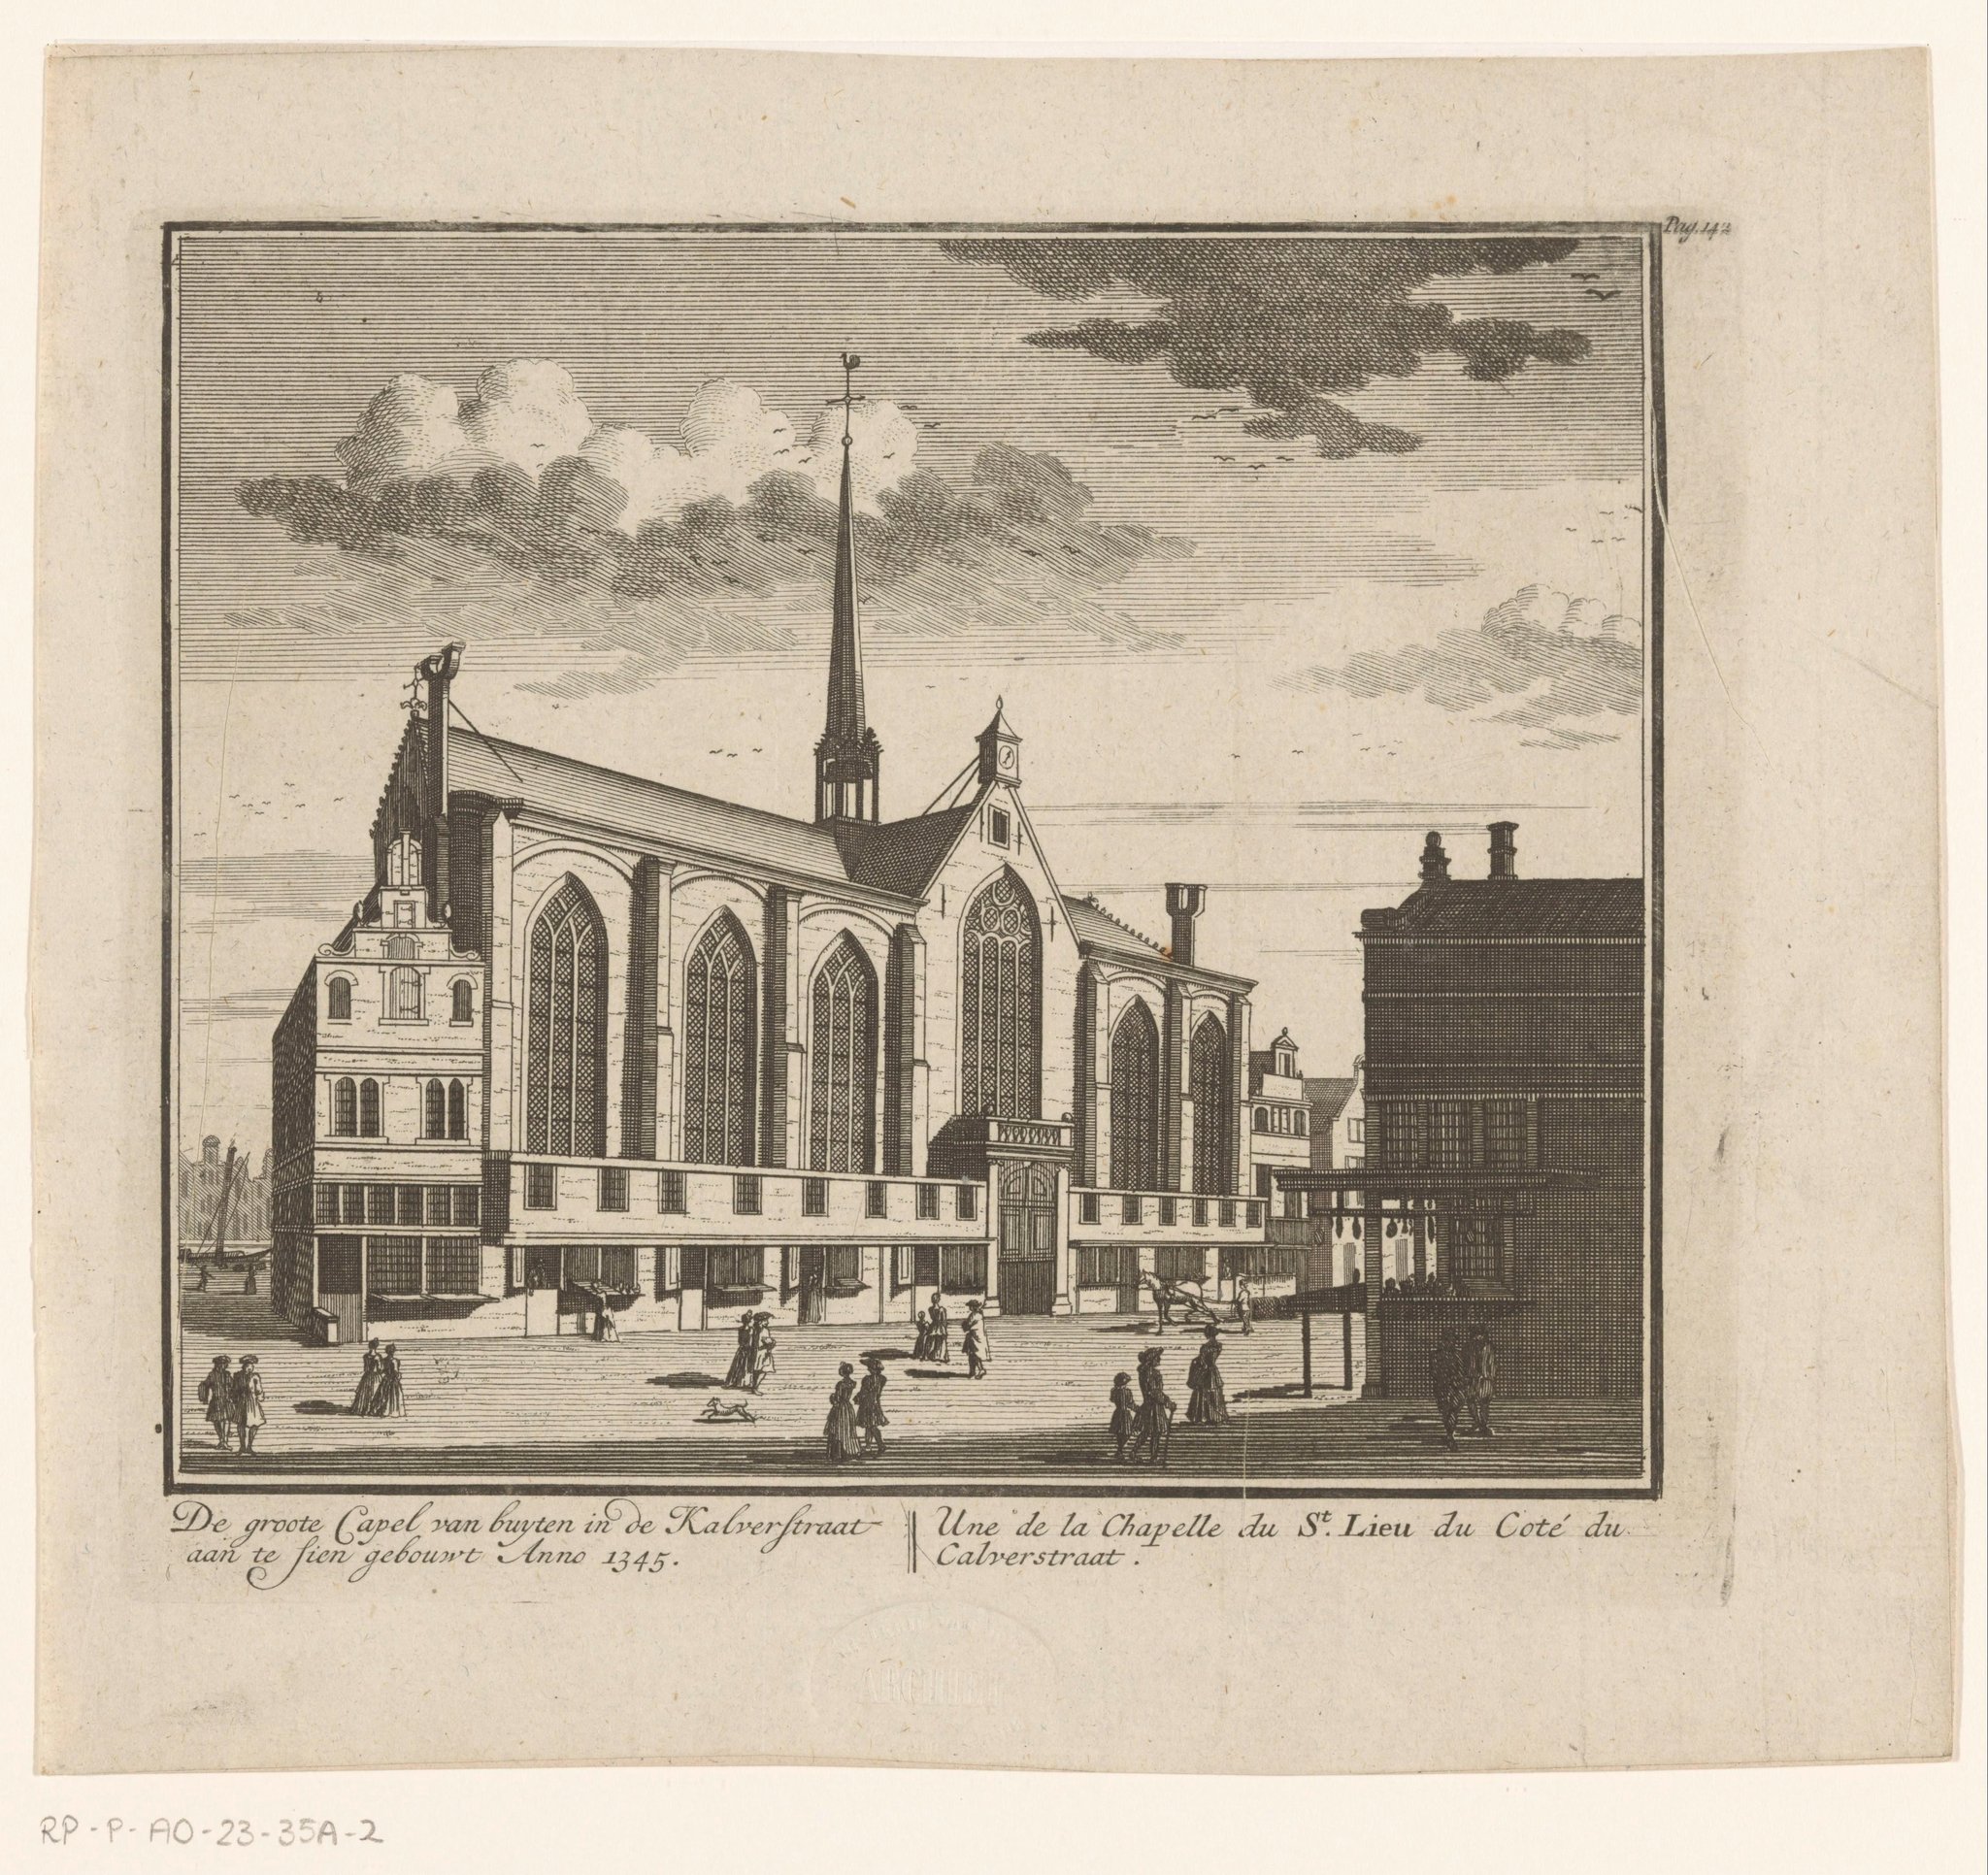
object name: book illustration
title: De groote Capel van buyten in de Kalverstraat aan te sien gebouwt Anno 1345 / Une de la Chapelle du St. Lieu du Coté du Calverstraat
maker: Anonymous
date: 1772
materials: paper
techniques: engraving, etching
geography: amsterdam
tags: church (exterior) - qq - small church, chapel, street (+ city(-scape) with figures, staffage)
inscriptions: check stamp: ‘Archief Ministerie van Oorlog Afdeeling Genie’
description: Prent ook gebruikt in: Le guide, ou nouvelle description d'Amsterdam; enseignant aux voyageurs, et aux negocians (…) Avec une description de sa belle Maison de Ville (…). Amsterdam: Covens & Mortier & Covens Jr., 1772, p. 142.